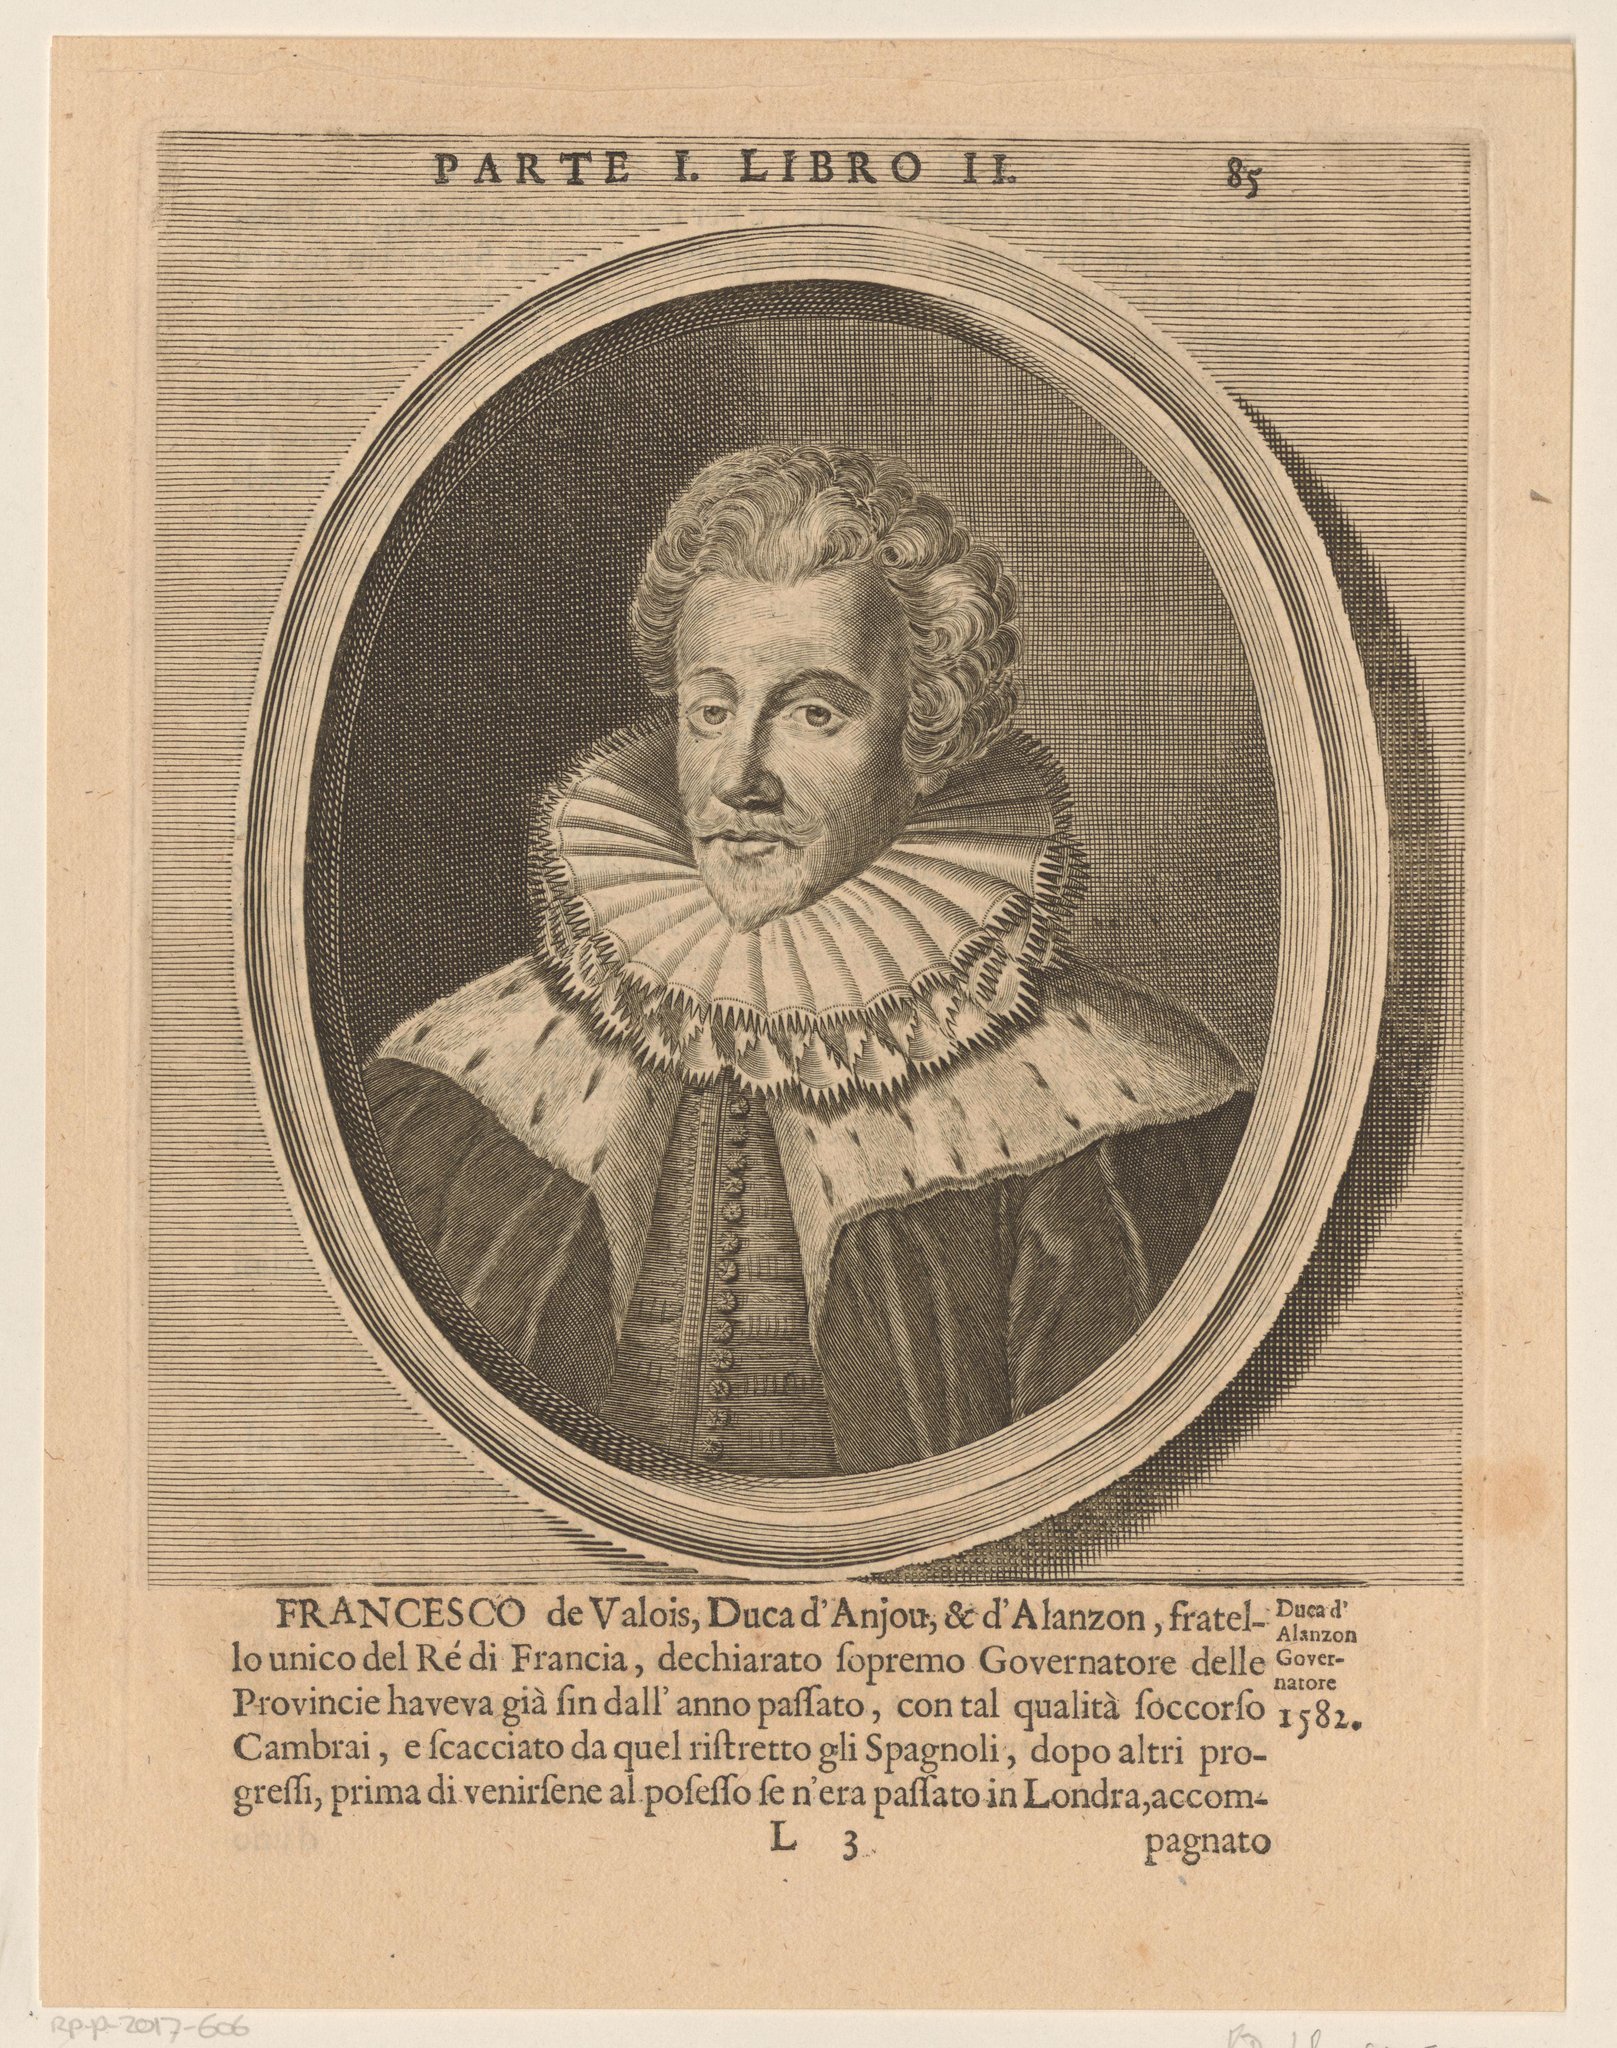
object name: print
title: Portret van François-Hercule de Valois, hertog van Anjou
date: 1690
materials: paper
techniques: engraving, letterpress printing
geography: amsterdam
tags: paris, françois-hercule de valois (hertog van anjou)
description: Prent uit: Leti, Gregorio. Teatro Belgico. Amsterdam: Willem de Jonge, 1690.